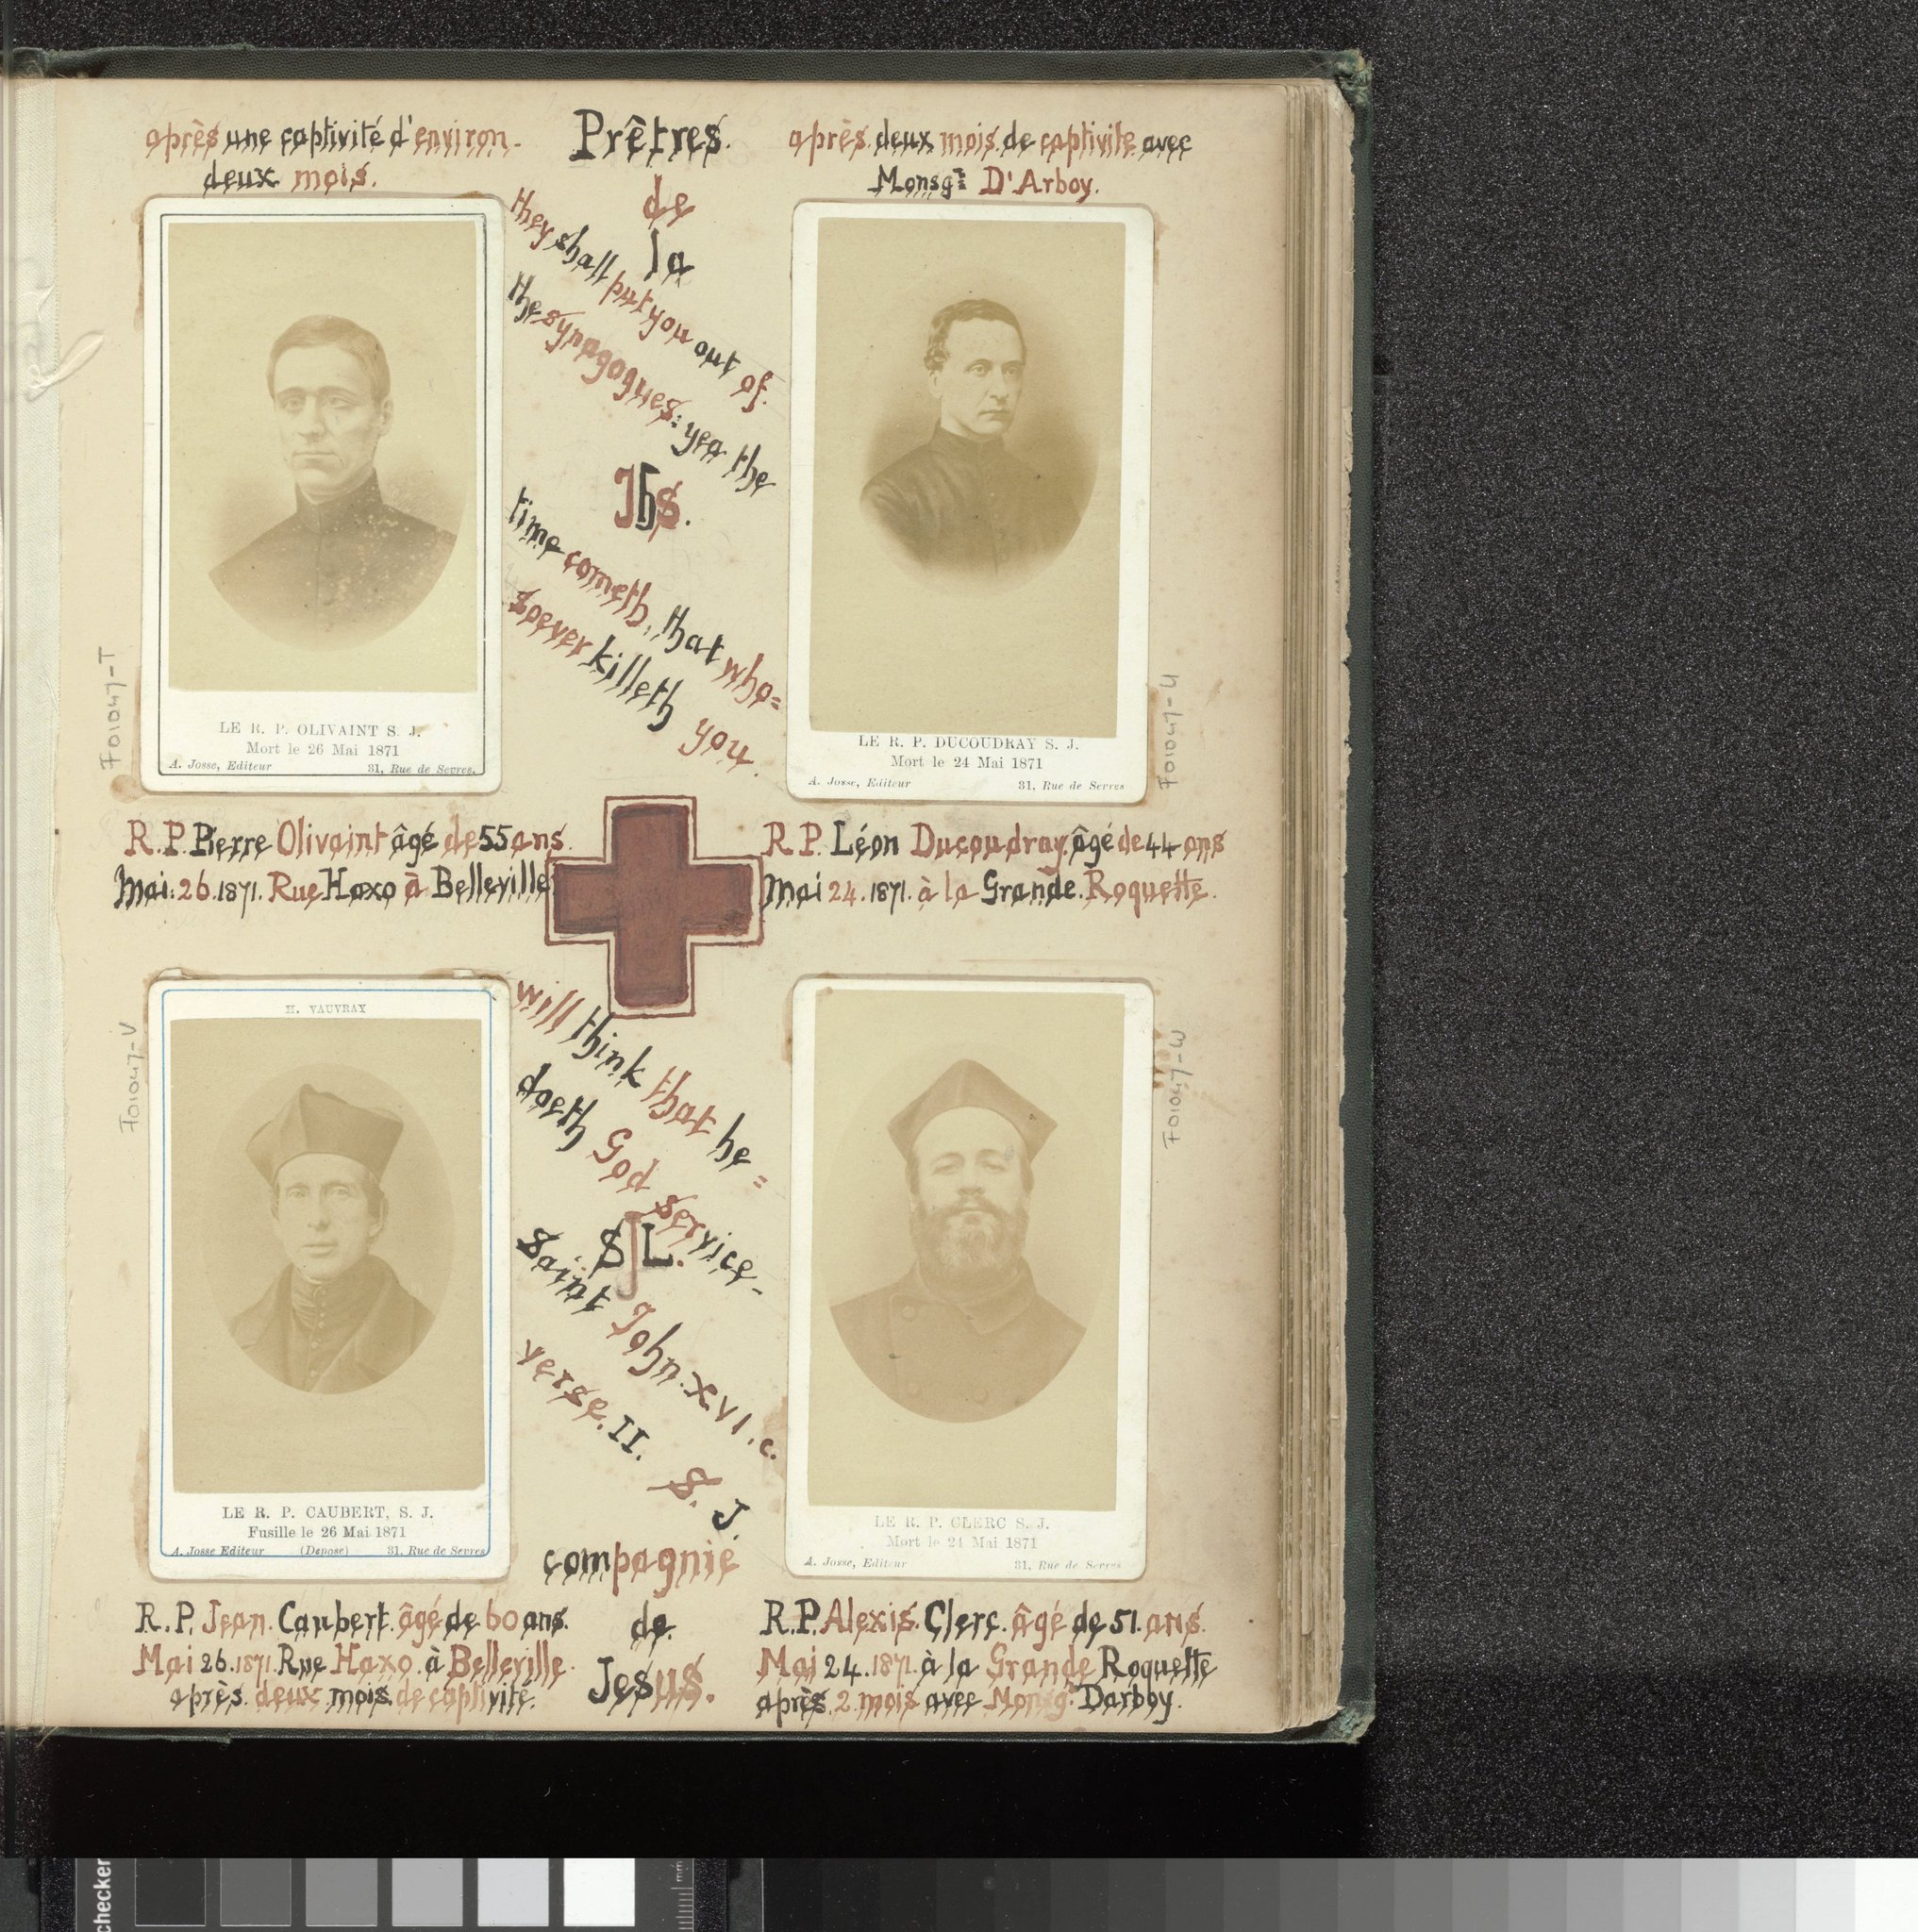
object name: album leaf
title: Portret van R.P. Clerc S.J.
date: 1871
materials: cardboard, paper, photographic support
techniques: albumen print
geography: paris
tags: priest (roman catholic)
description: Onderdeel van Herdenkingsalbum van rooms-katholieke geestelijken gevallen tijdens de Commune van Parijs.